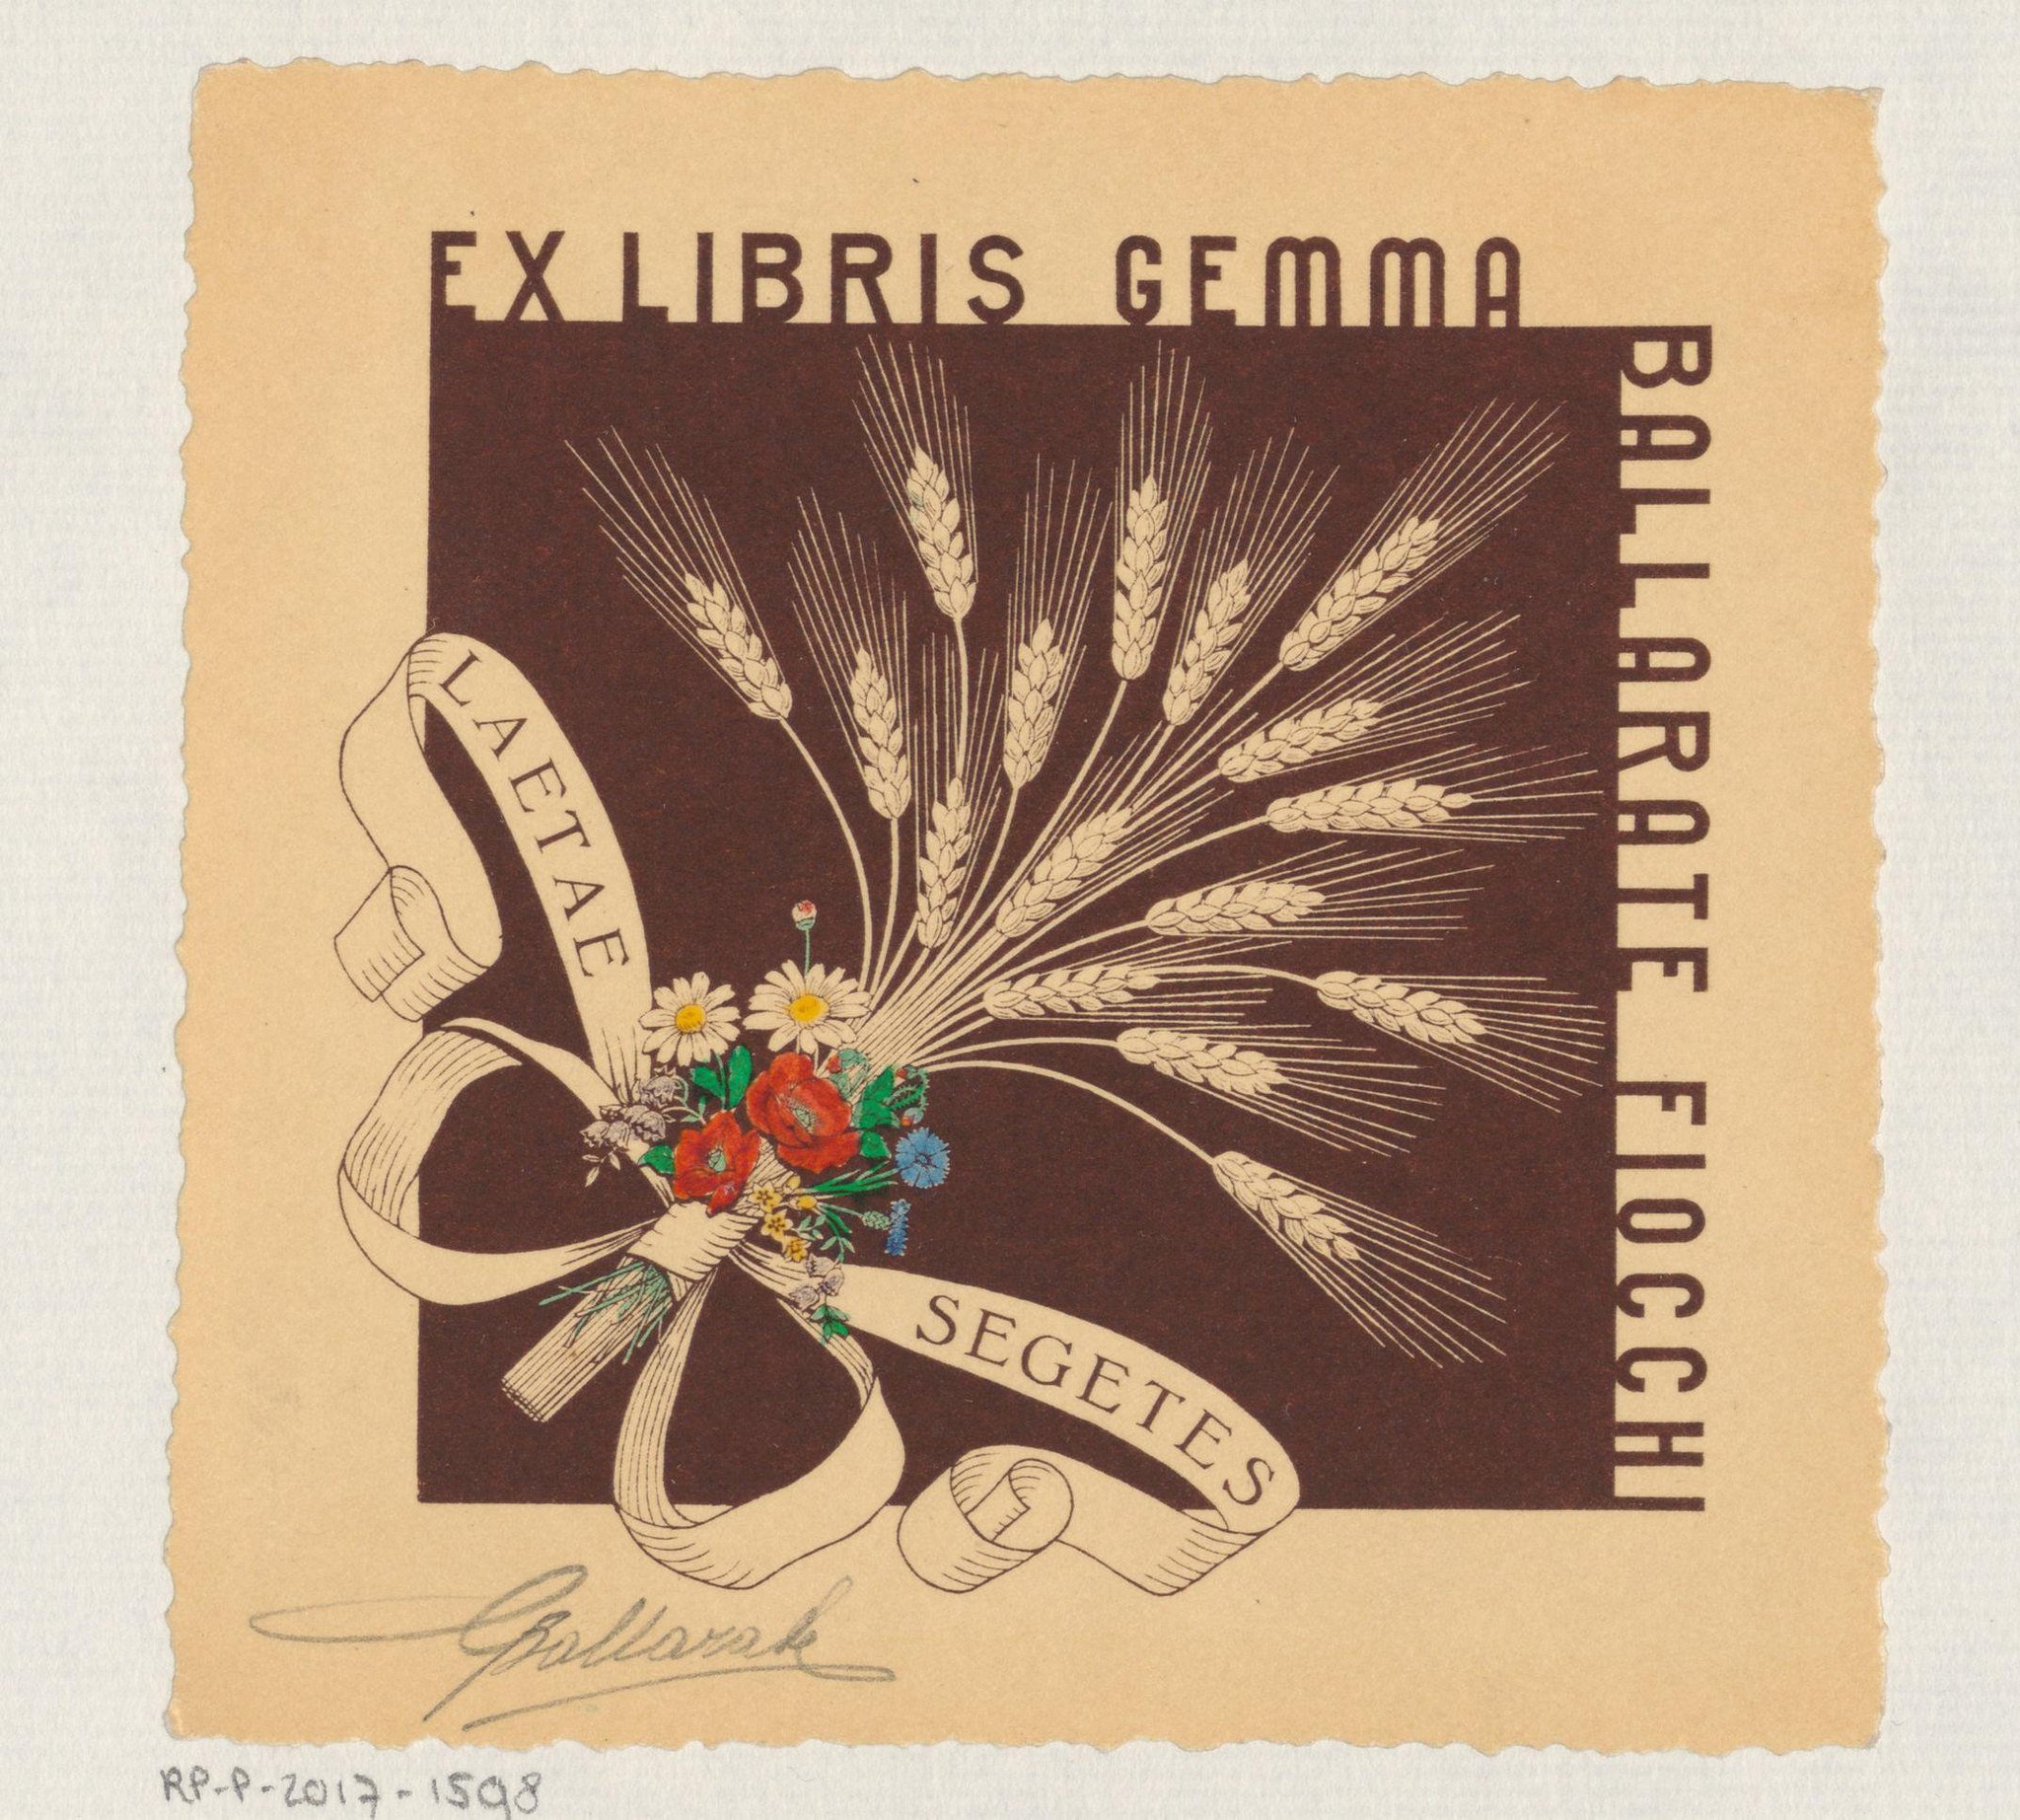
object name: bookplate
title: Ex libris van Gemma Ballarate Fiocchi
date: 1930-1960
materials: paper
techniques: hand coloring, printing block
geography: italy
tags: print maker, gemma ballarate fiocchi, cut flowers; nosegay, bunch of flowers, ear of corn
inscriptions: signature: ‘G Ballarate’